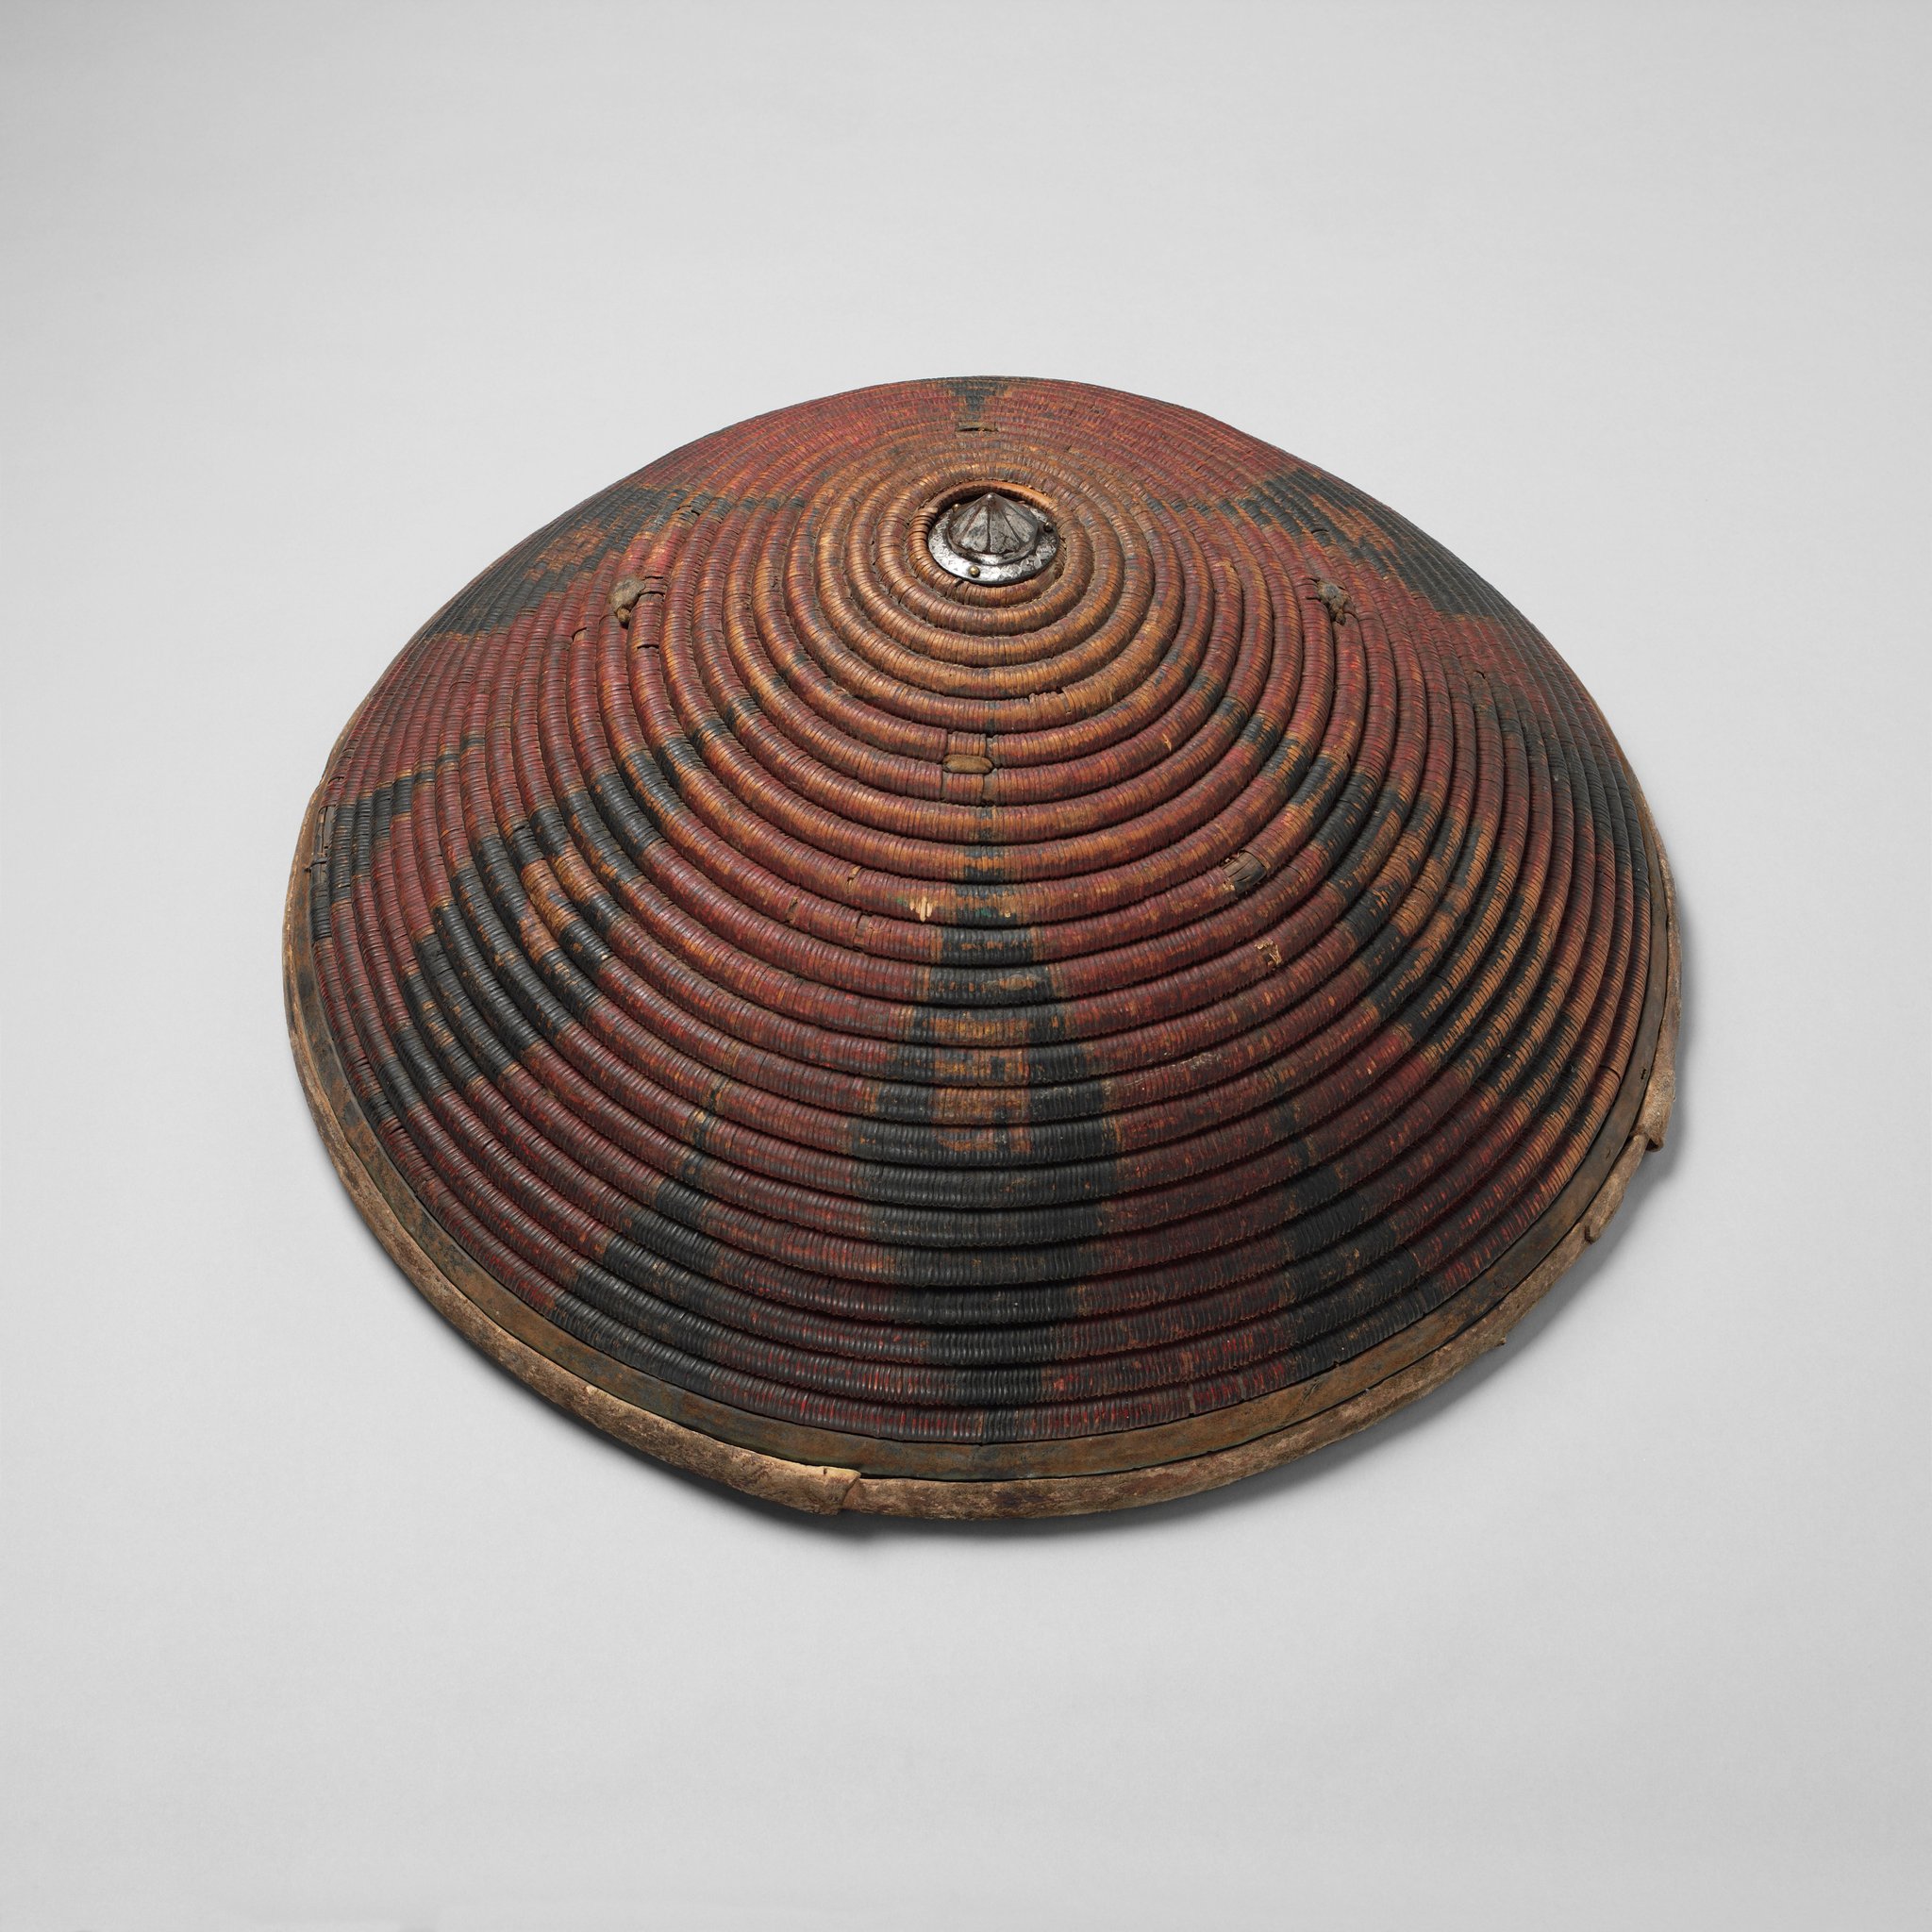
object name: shield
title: Domed Shield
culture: tibetan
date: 1401-1800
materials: brass, iron, leather, pigment, silver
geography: tibet